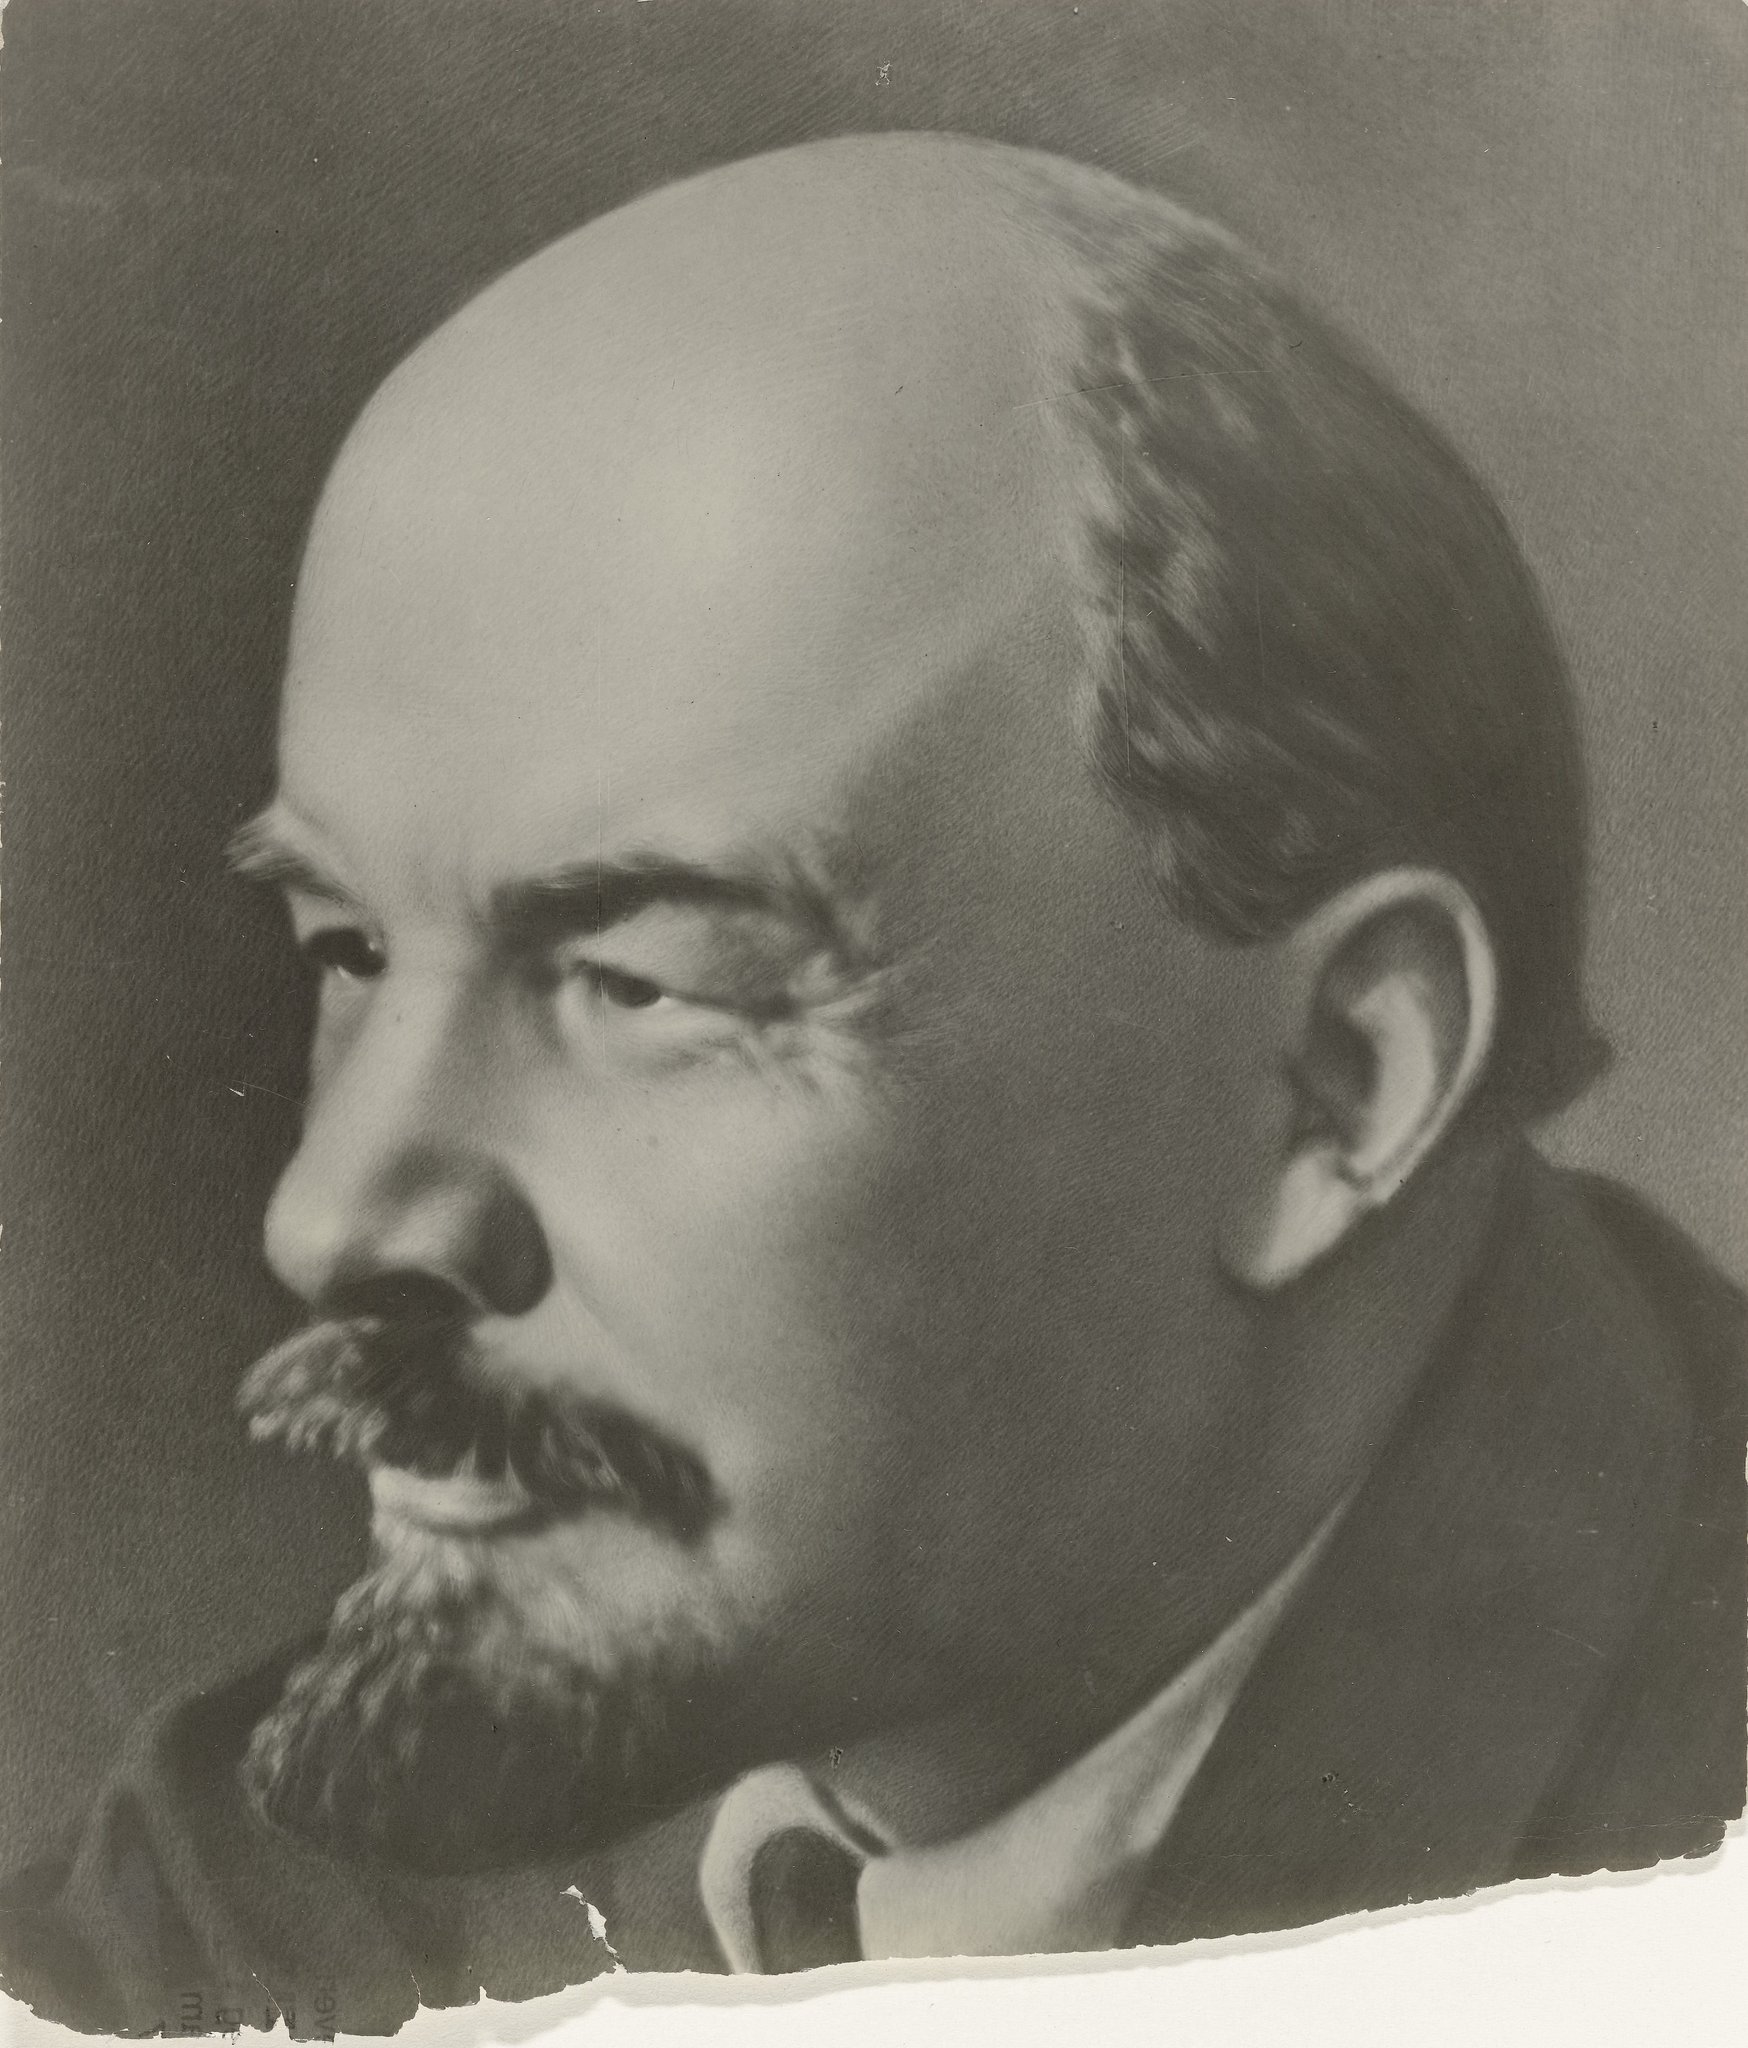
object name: photograph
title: Portret van Lenin uit de werkkamer van Paul de Groot, voorzitter van de CPN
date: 1920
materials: photographic support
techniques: photography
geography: soviet union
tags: amsterdam, politician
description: Portretfoto van Wladimir Iljitch Uljanov (Lenin) in drie-kwart. De foto is geretoucheerd, waarschijnlijk al op het negatief. Lenin heeft hier en daar grijs haar. Aan de onderzijde ontbreek een rand van het fotopapier. Op de achterzijde staan diverse stempels: 'Printed in de Union of Soviet Socialist Republics' en een rood stempel met de datum 18 januari 1952. In potlood: 'Waarheid' (het CPN-dagblad) en 'spiegelen'. Op de achterkant zit oude lijm. Bovenin de foto zit een gaatje van een punaise.